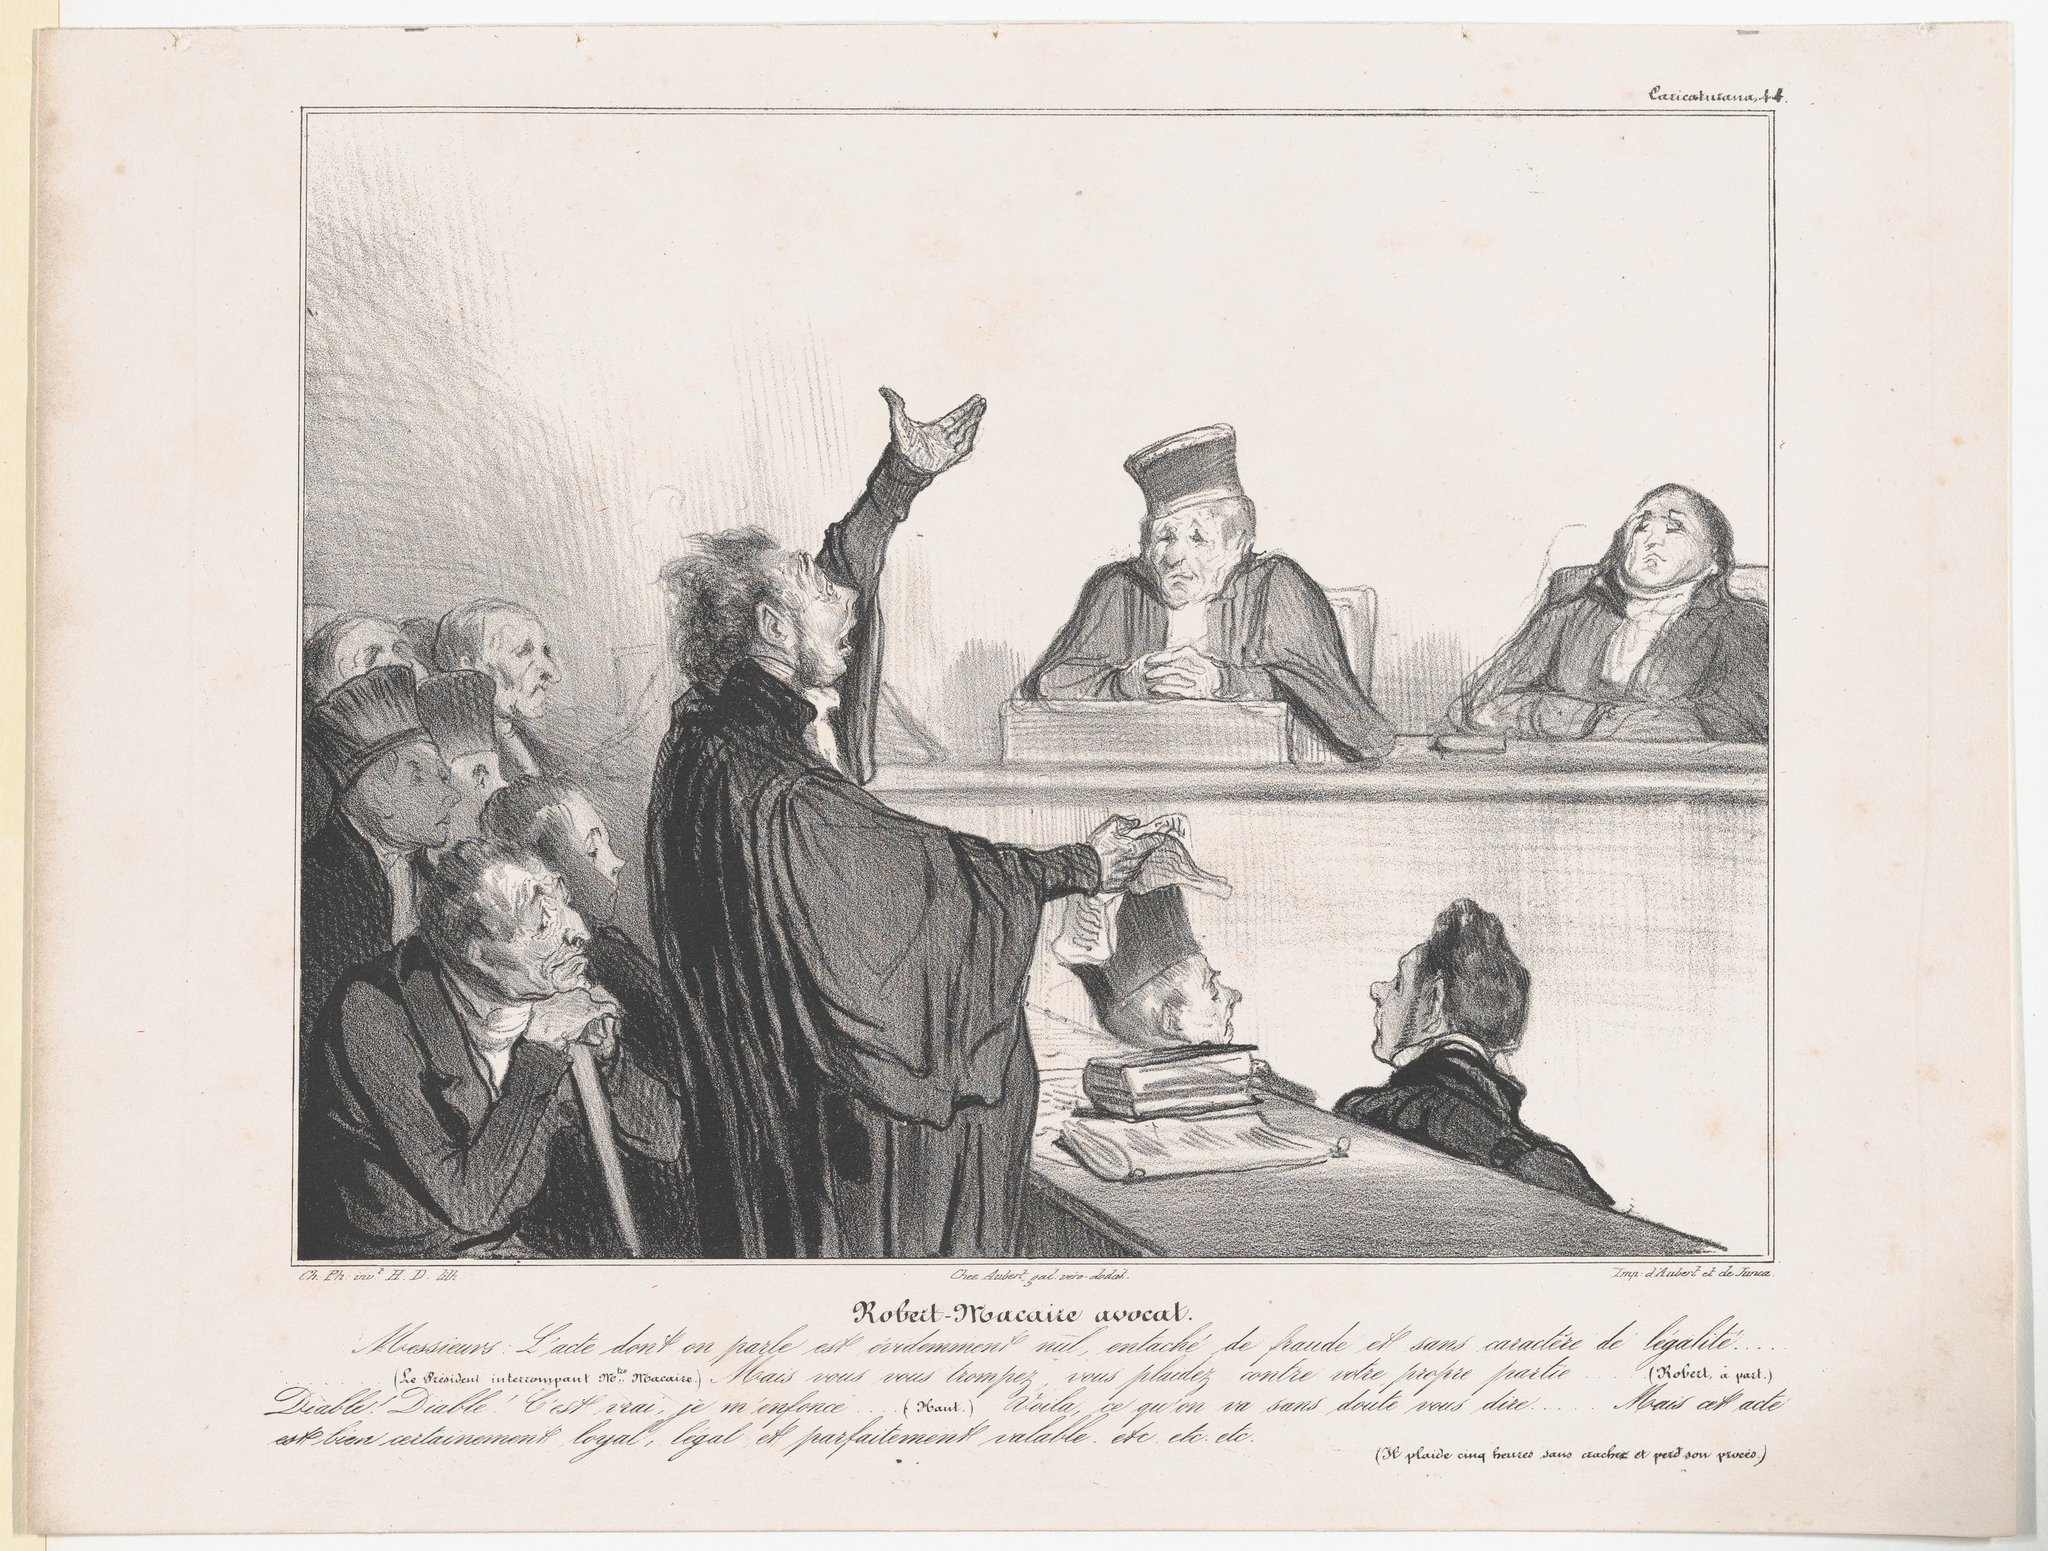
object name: print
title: Plate 44: Robert Macaire, Barrister, from 'Caricaturana,' published in Les Robert Macaires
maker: honoré daumier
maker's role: artist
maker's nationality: french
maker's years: 1808-1879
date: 1838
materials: paper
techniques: lithograph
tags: men